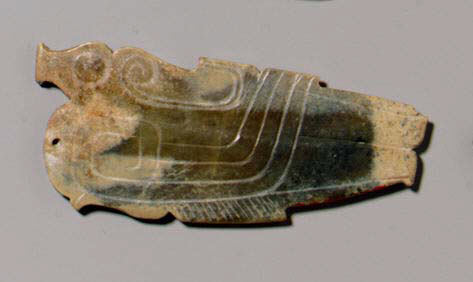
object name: plaque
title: Plaque in the Shape of a Bird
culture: chinese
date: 1200-1001 BCE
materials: jade